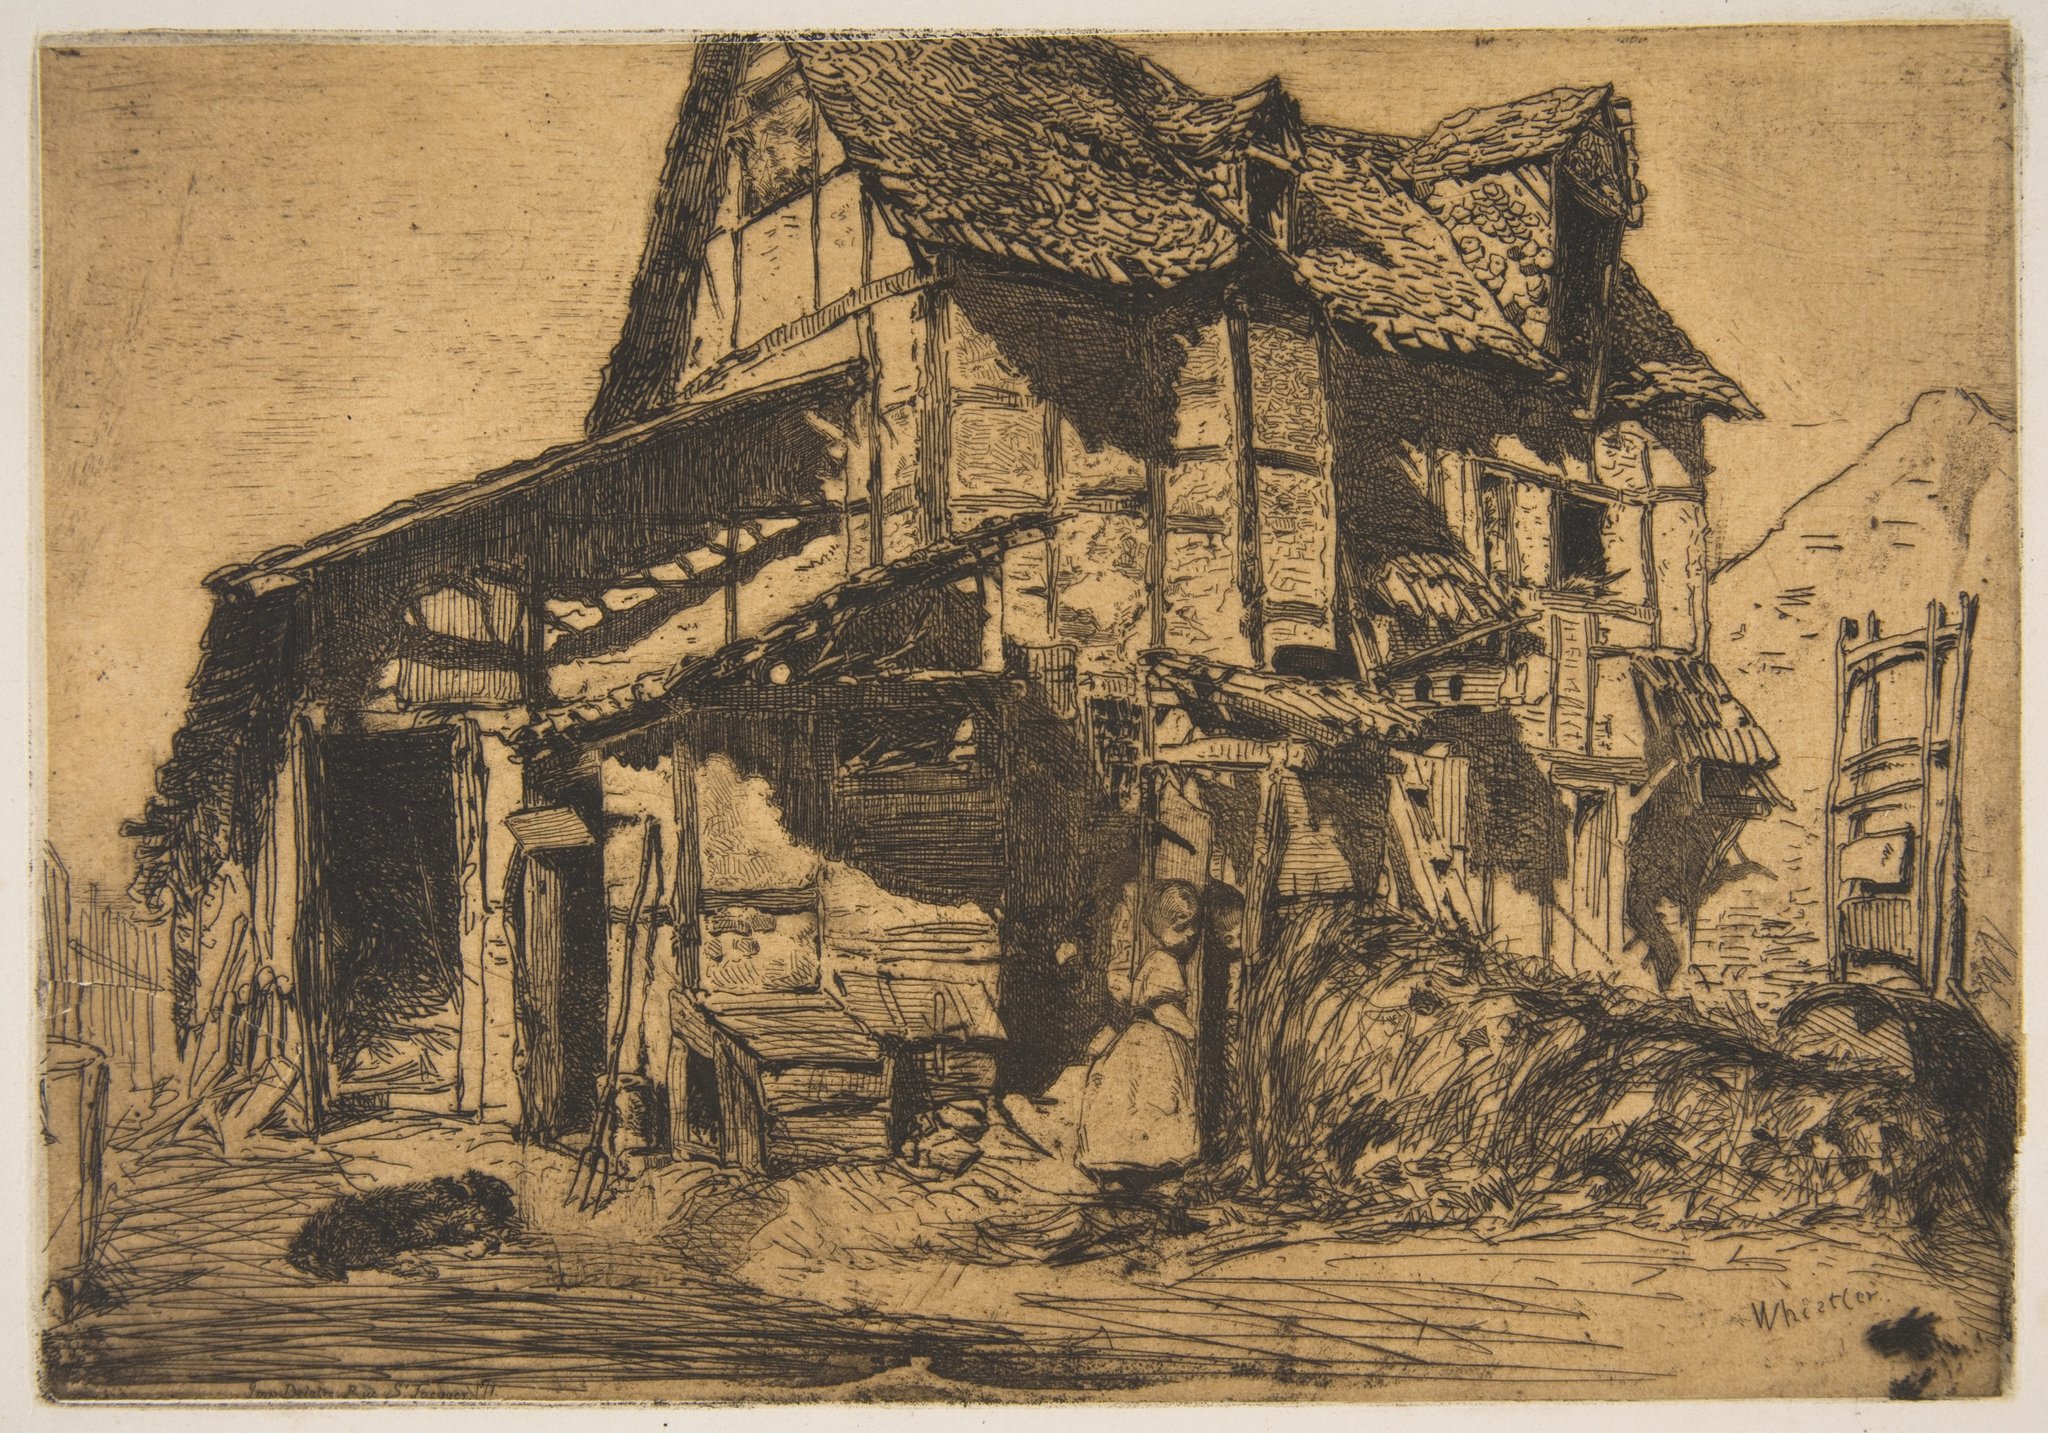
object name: print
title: The Unsafe Tenement (The Old Farm)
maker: james mcneill whistler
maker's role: artist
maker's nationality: american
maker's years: 1834-1903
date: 1858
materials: chine, ink, paper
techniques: printmaking, etching, printing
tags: farms,girls